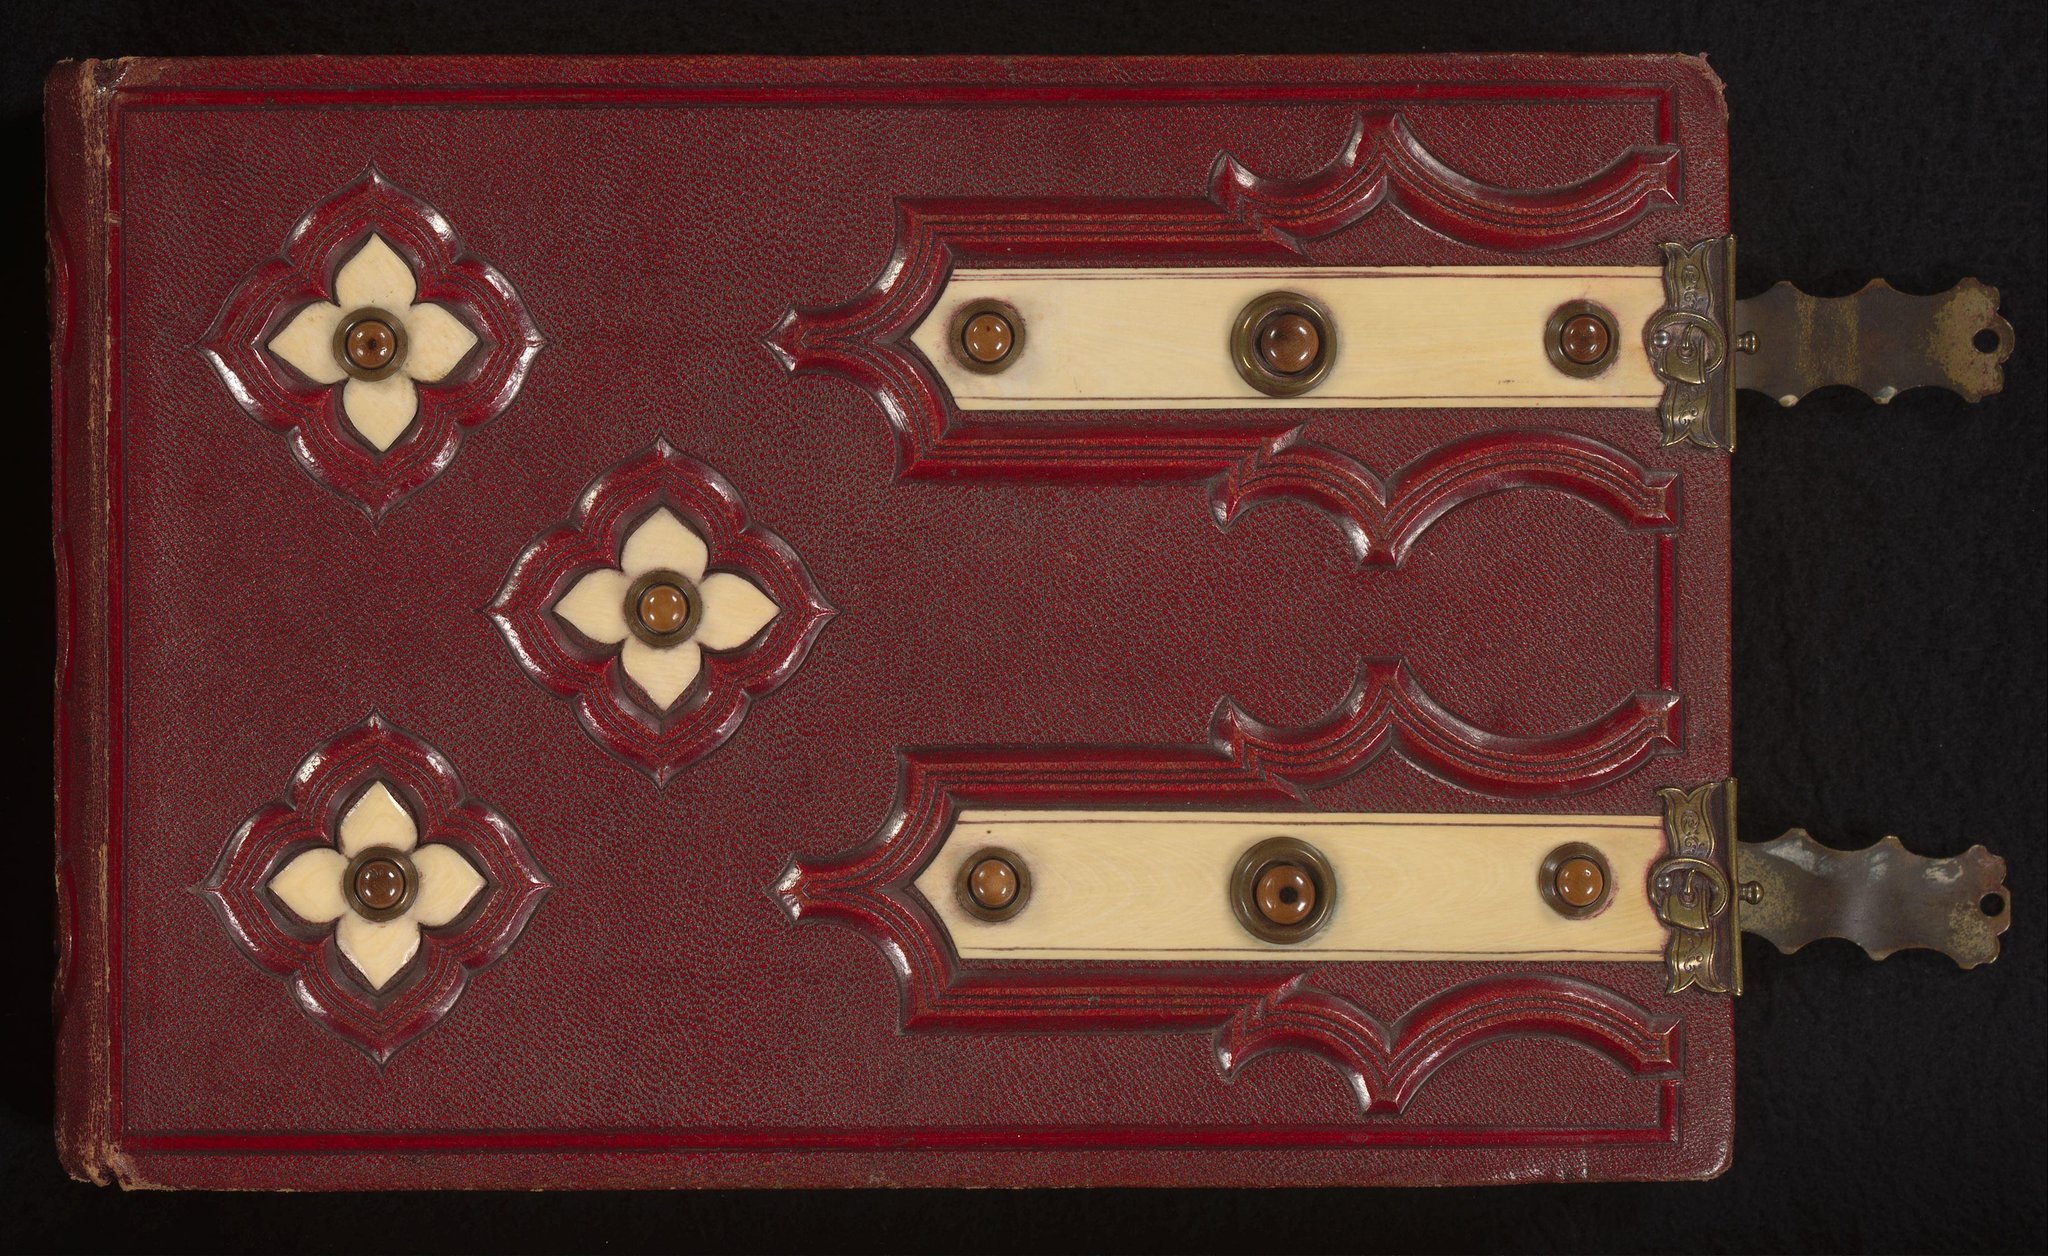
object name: slip in album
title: Fotoalbum met 100 foto's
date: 1850-1900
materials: cardboard, copper, leather, paper, photographic support, plastic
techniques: albumen print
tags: sideburns, sitting figure - aa - female human figure, historical persons - bb - woman, boy (child between toddler and youth), historical persons, girl (child between toddler and youth), beard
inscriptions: collector's mark: ‘Dienst Verspreide Rijkscollekties/ Inv.nr: A912’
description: Fotoalbum met 25 bladen met in totaal 100 foto's. Het album bevat voornamelijk portretten van anonieme personen. Slechts bij enkele personen wordt een naam vermeld. De portretten zijn voornamelijk vervaardigd in Nederland en Frankrijk, enkele zijn afkomstig uit Duitsland, België en Indonesië. Enkele vervaardigers zijn Wegner & Mottu, Albert Greiner en Jean Baptiste Durdik.